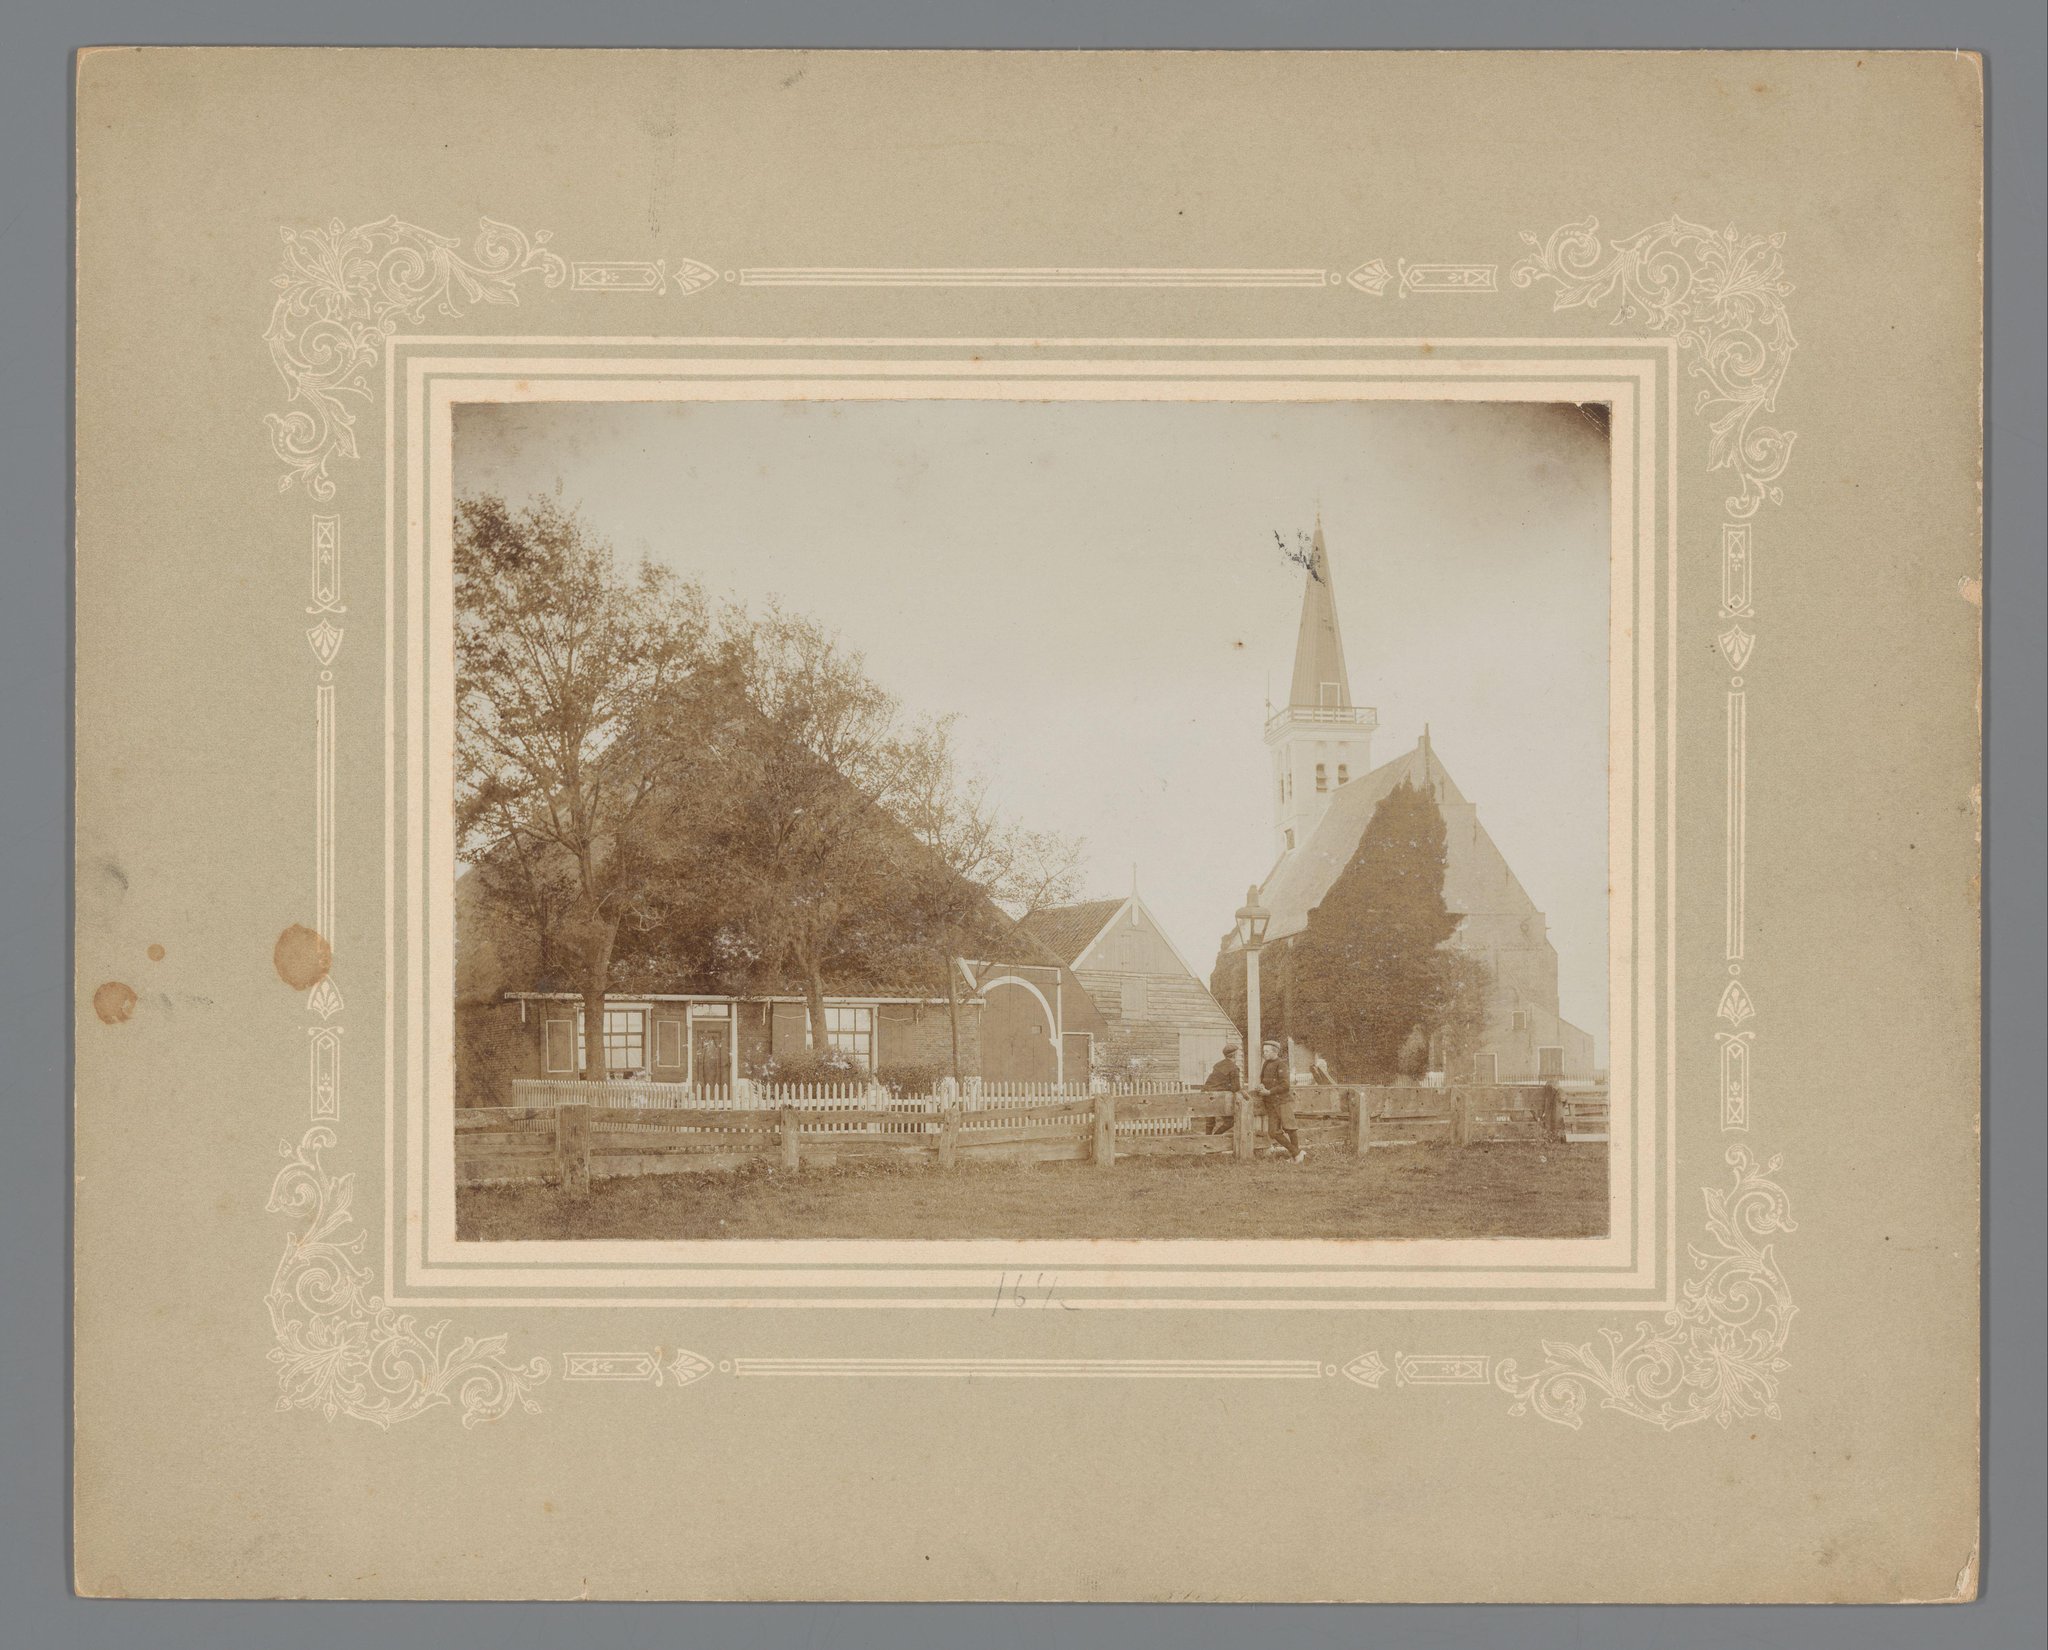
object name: photograph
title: Gezicht op een boerderij en de Hervormde Kerk te Den Hoorn, Texel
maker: Anonymous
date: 1890-1910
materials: cardboard, photographic support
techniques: collodion silver print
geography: den hoorn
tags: church (exterior), farm (building)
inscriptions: annotation: ‘Kerk te Den Hoorn Texel’, annotation: ‘16 1/2’